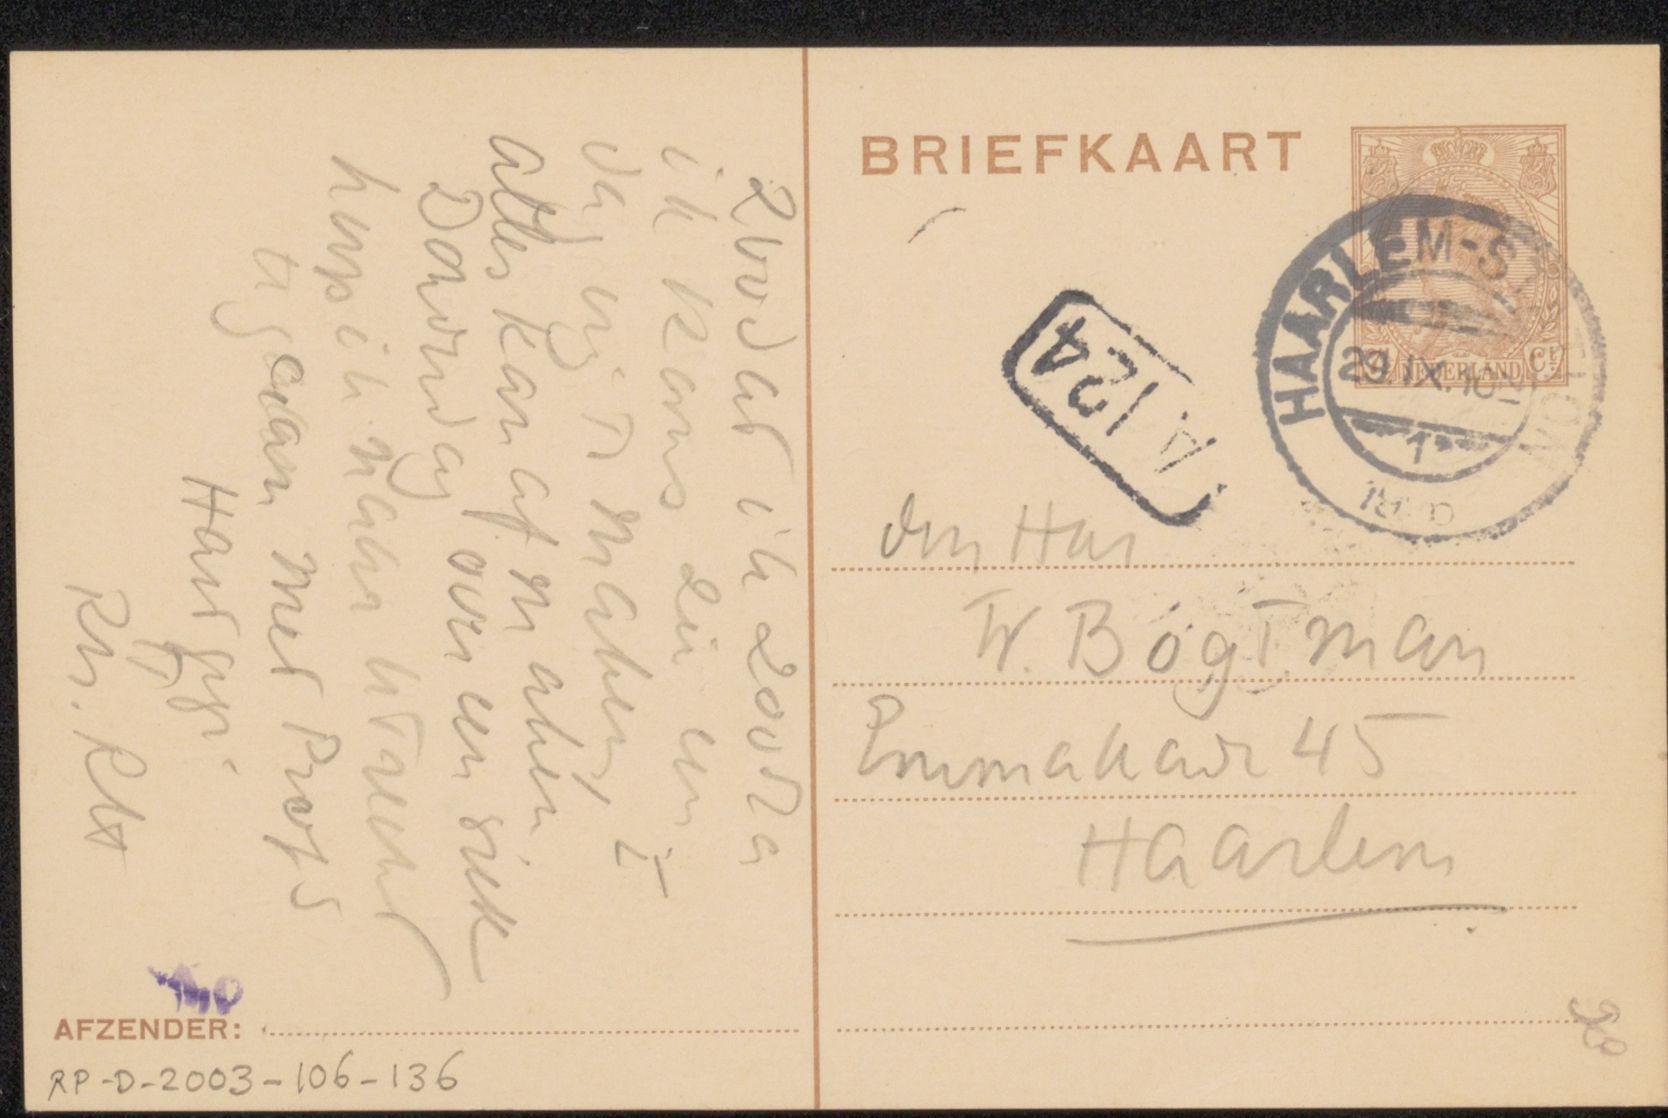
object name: postcard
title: Briefkaart aan Willem Bogtman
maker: richard nicolaüs roland holst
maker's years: 1868-1938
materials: cardboard, pencil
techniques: pen, writing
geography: haarlem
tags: indonesia, the hague, haarlem, willem bogtman, applied arts, arts and crafts; industrial design